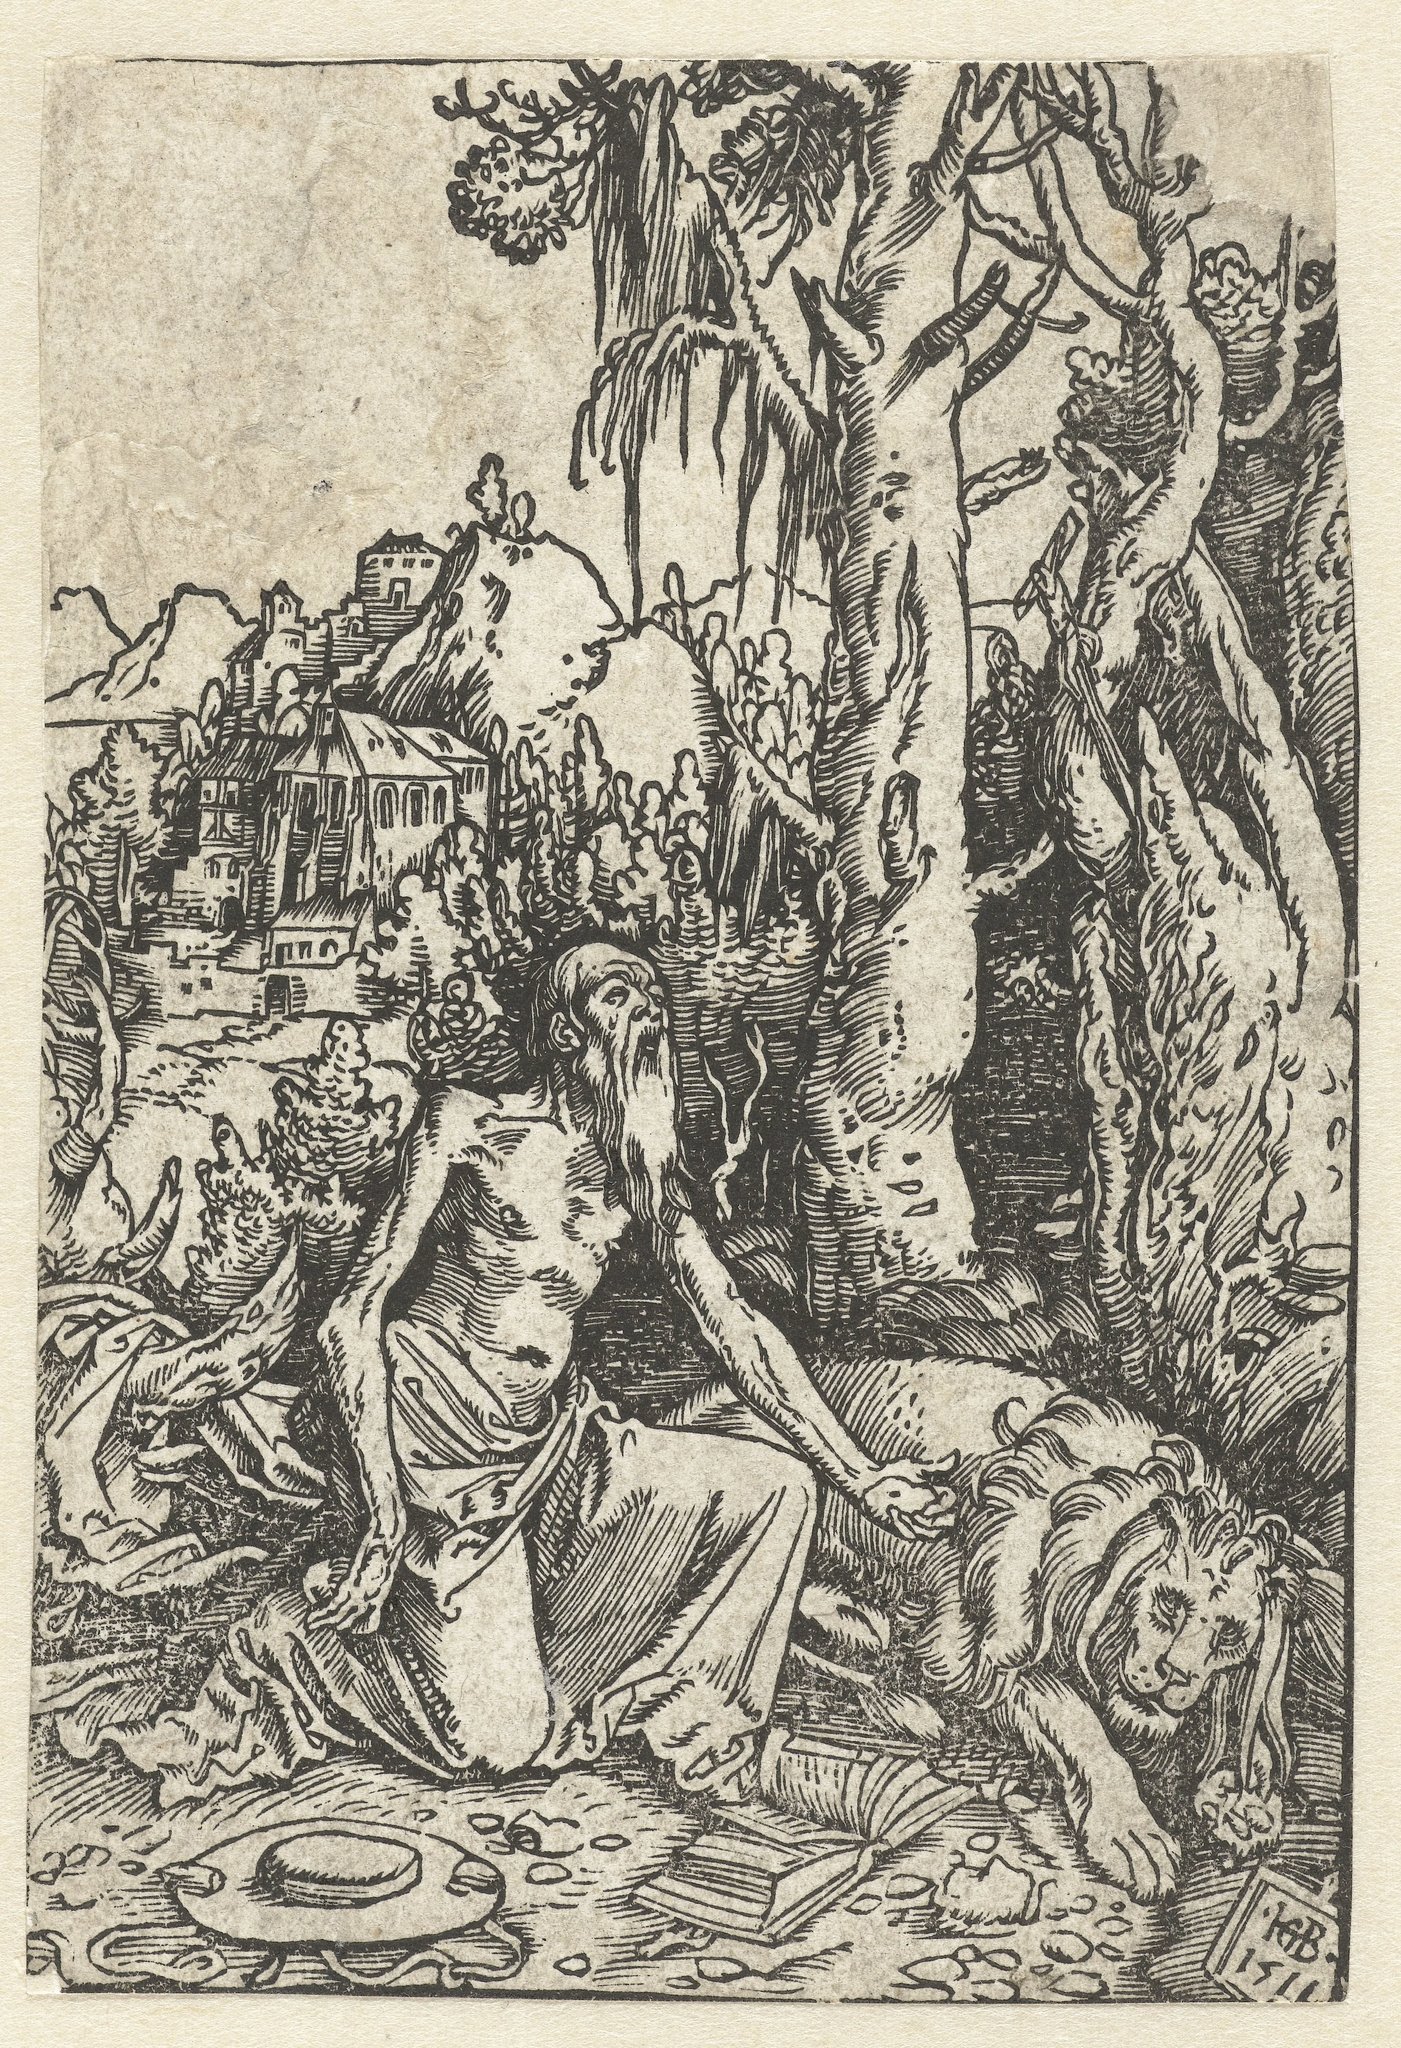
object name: print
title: Heilige Hieronymus als boeteling in de woestijn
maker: hans baldung grien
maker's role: draughtsman, print maker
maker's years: 1484-1545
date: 1511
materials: paper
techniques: woodcut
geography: straatsburg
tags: st. jerome as penitent in the desert, half naked, kneeling before a crucifix and holding a stone in his hand to beat his breast; a skull (and other 'vanitas' symbols), sometimes a scorpion and a snake beside him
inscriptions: collector's mark: Lugt 240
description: De heilige Hieronymus knielt als boeteling in de woestijn of wildernis bij een boom. Hij is weergegeven als een magere oude man met een steen in zijn hand. Naast hem ligt een leeuw en op de grond voor hem liggen nog twee attributen, een kardinaalshoed en een boek. Links is een vergezicht met een berglandschap en een kerk weergegeven.